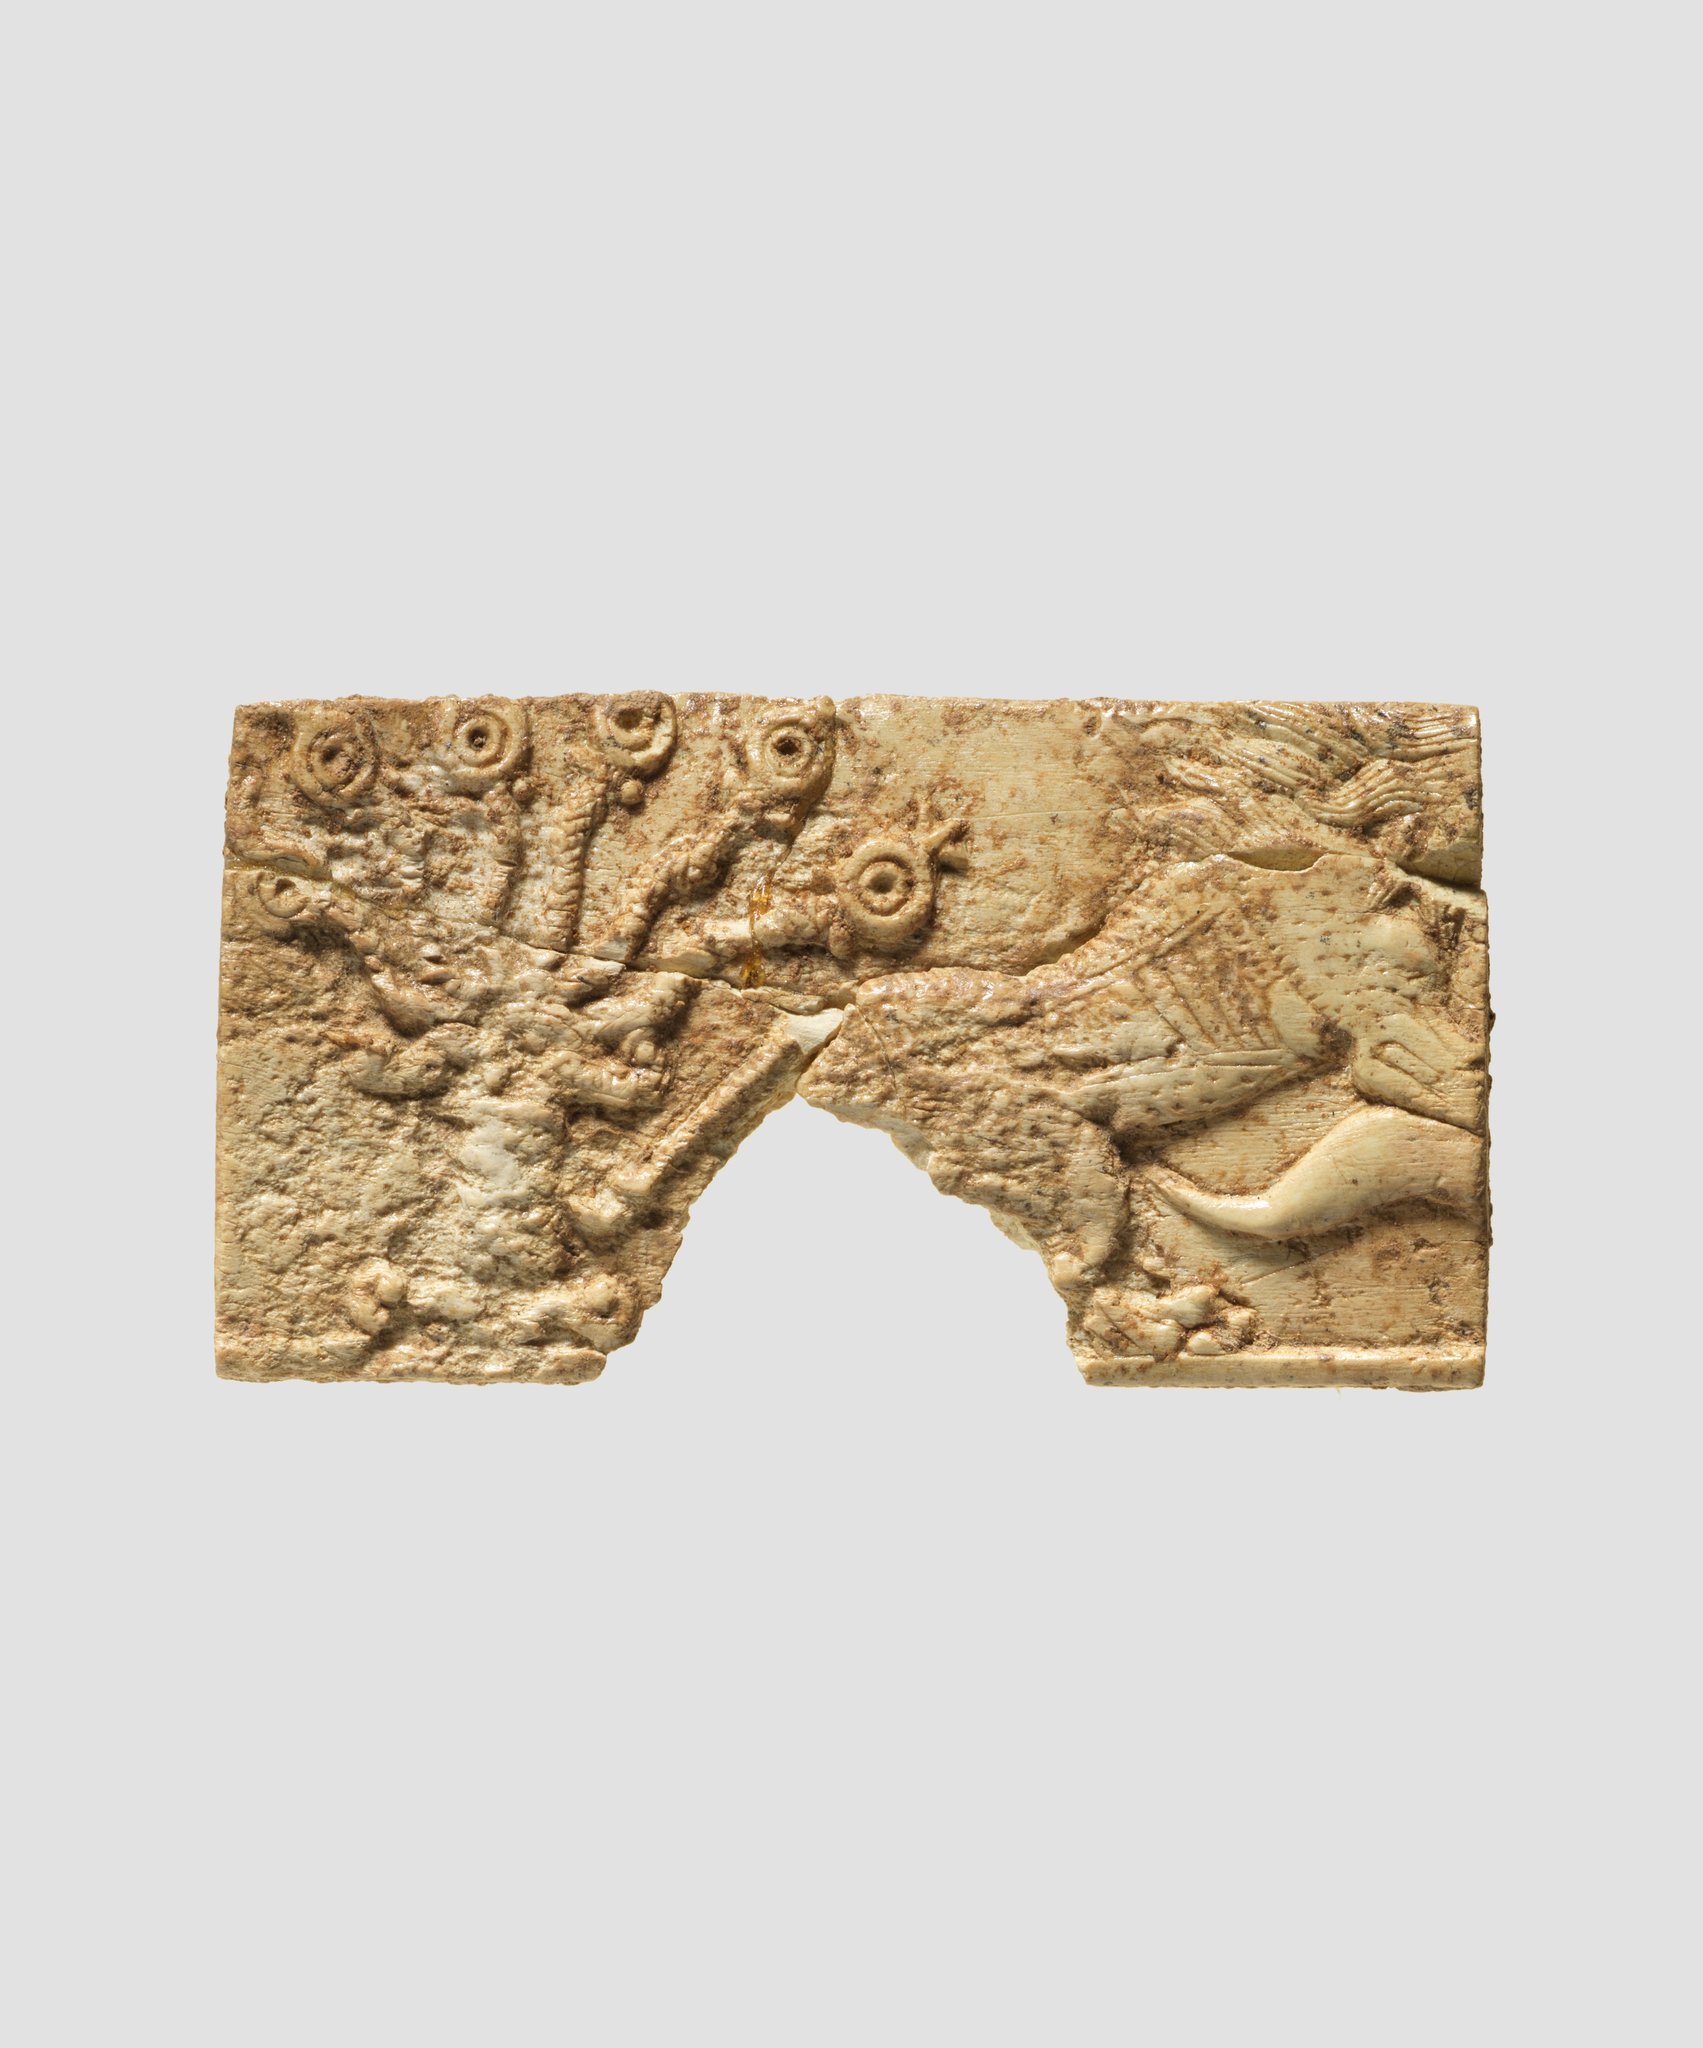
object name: relief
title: Panel fragment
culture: iranian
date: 800-601 BCE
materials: ivory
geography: iran